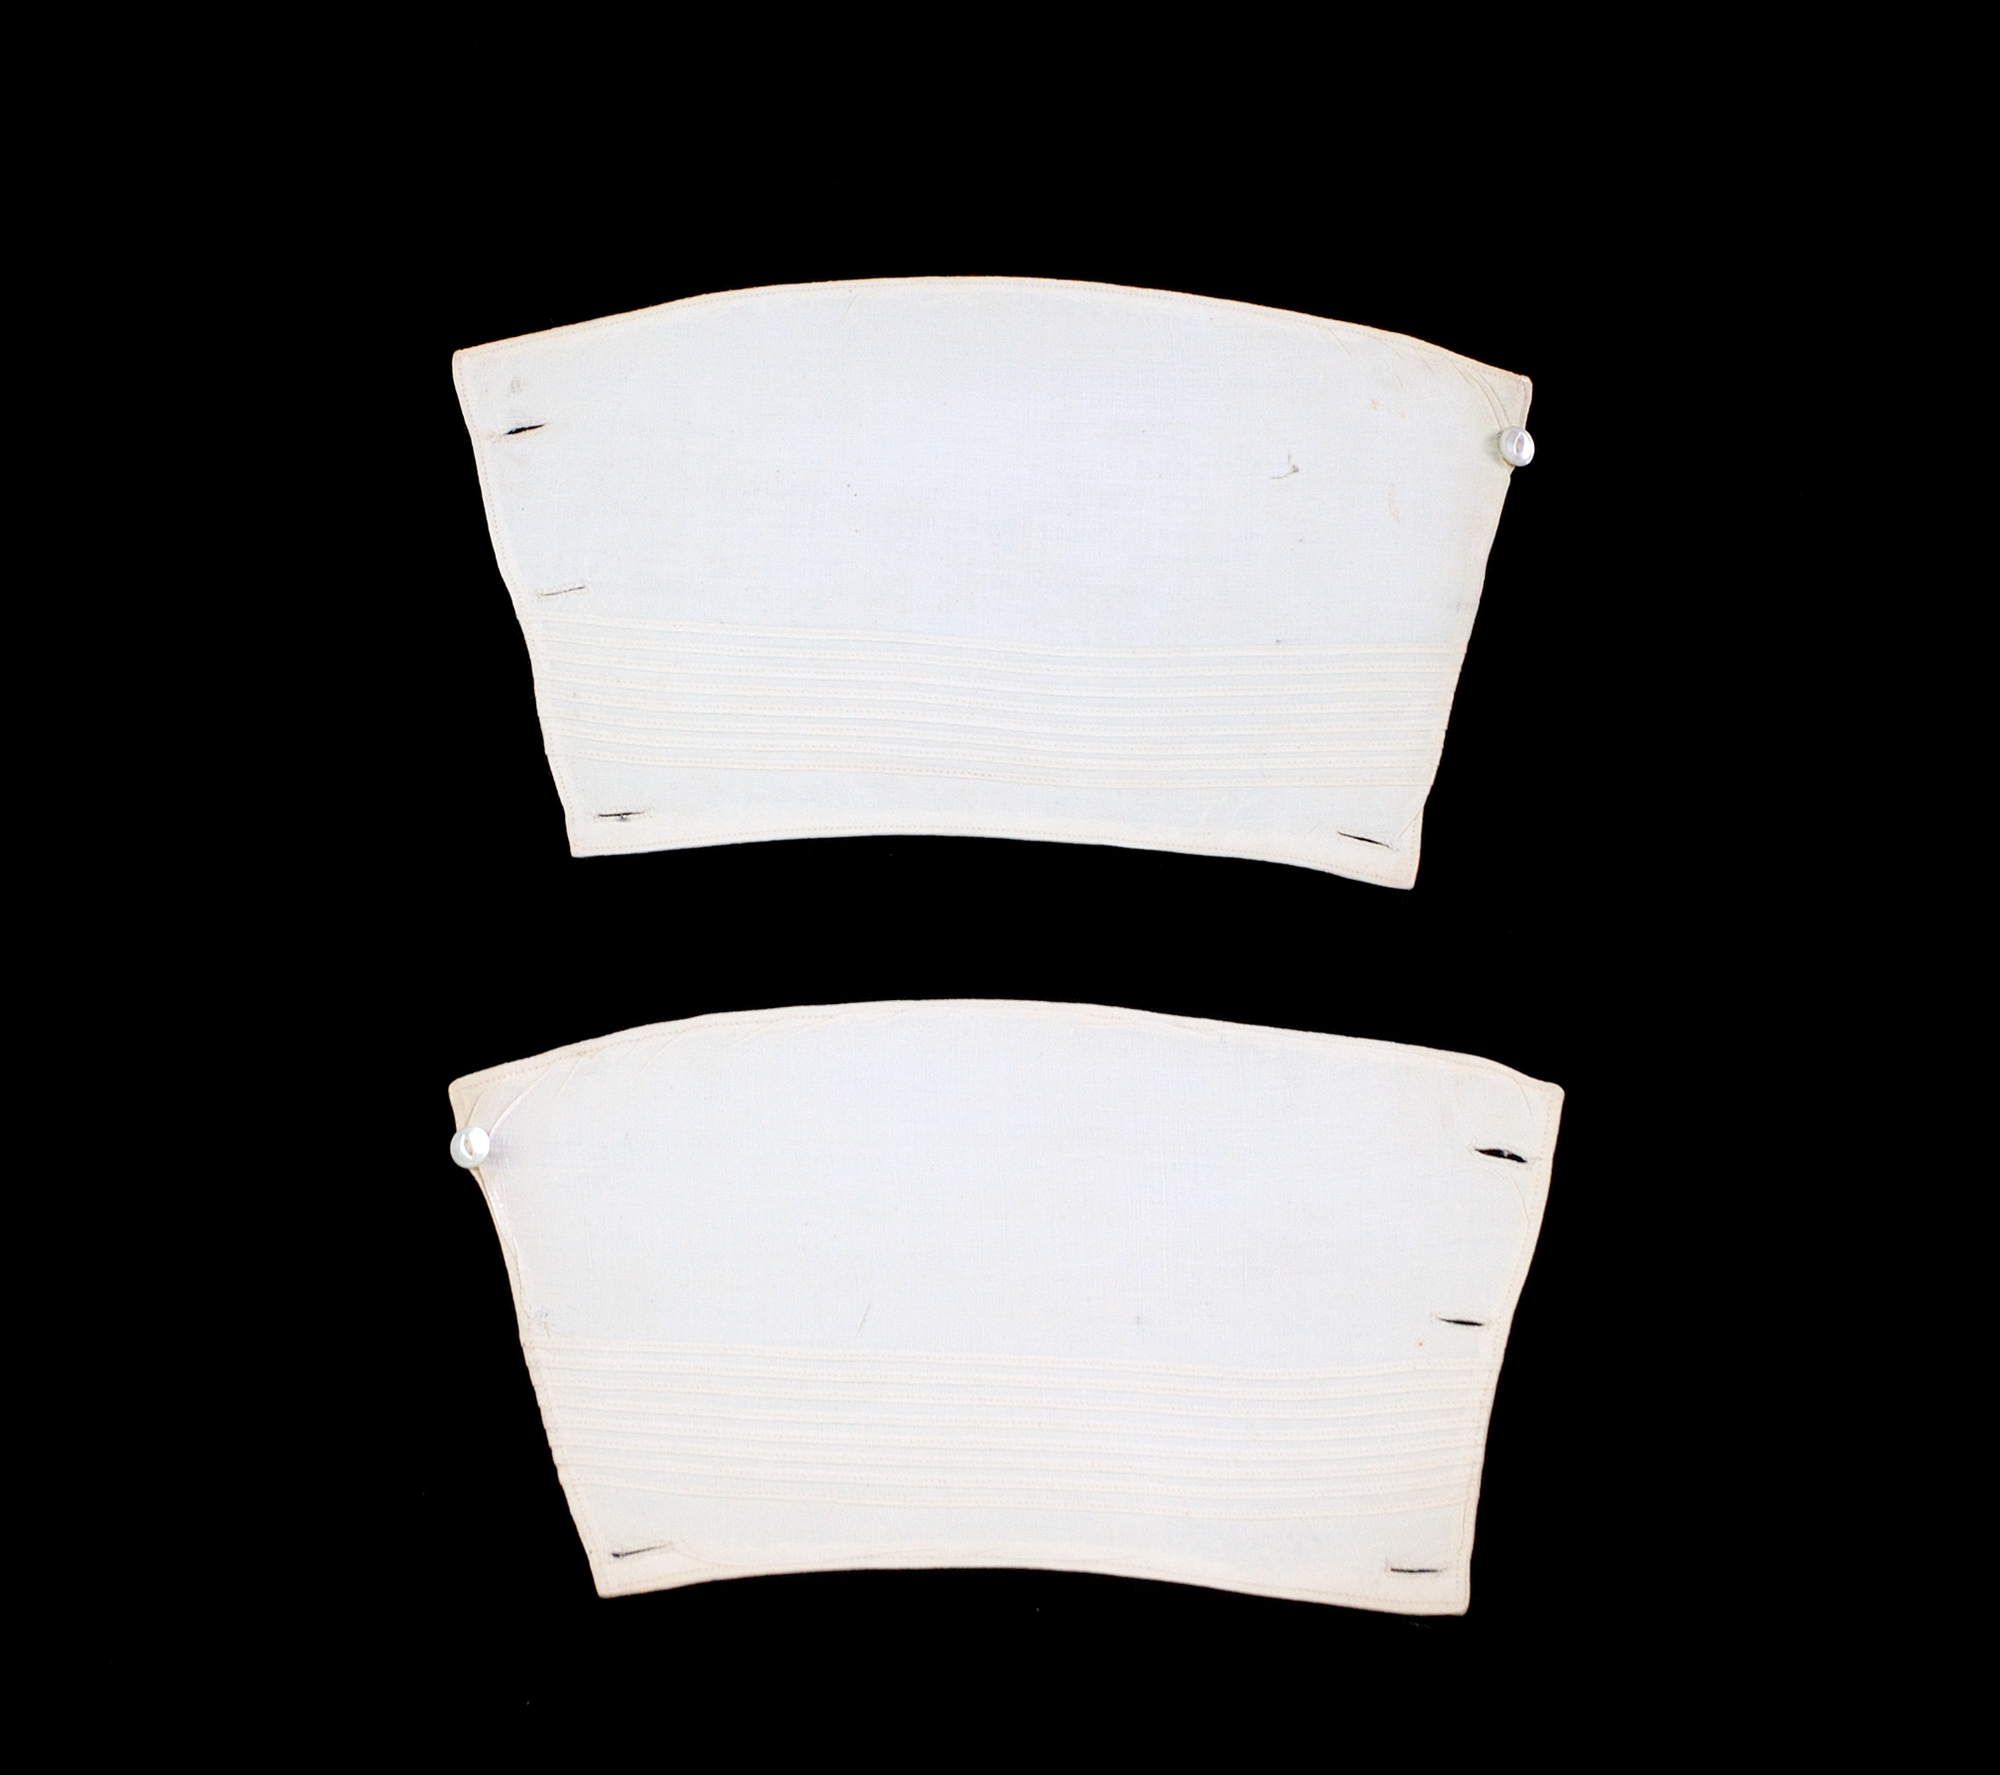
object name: cuff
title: Cuffs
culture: american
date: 1875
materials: linen